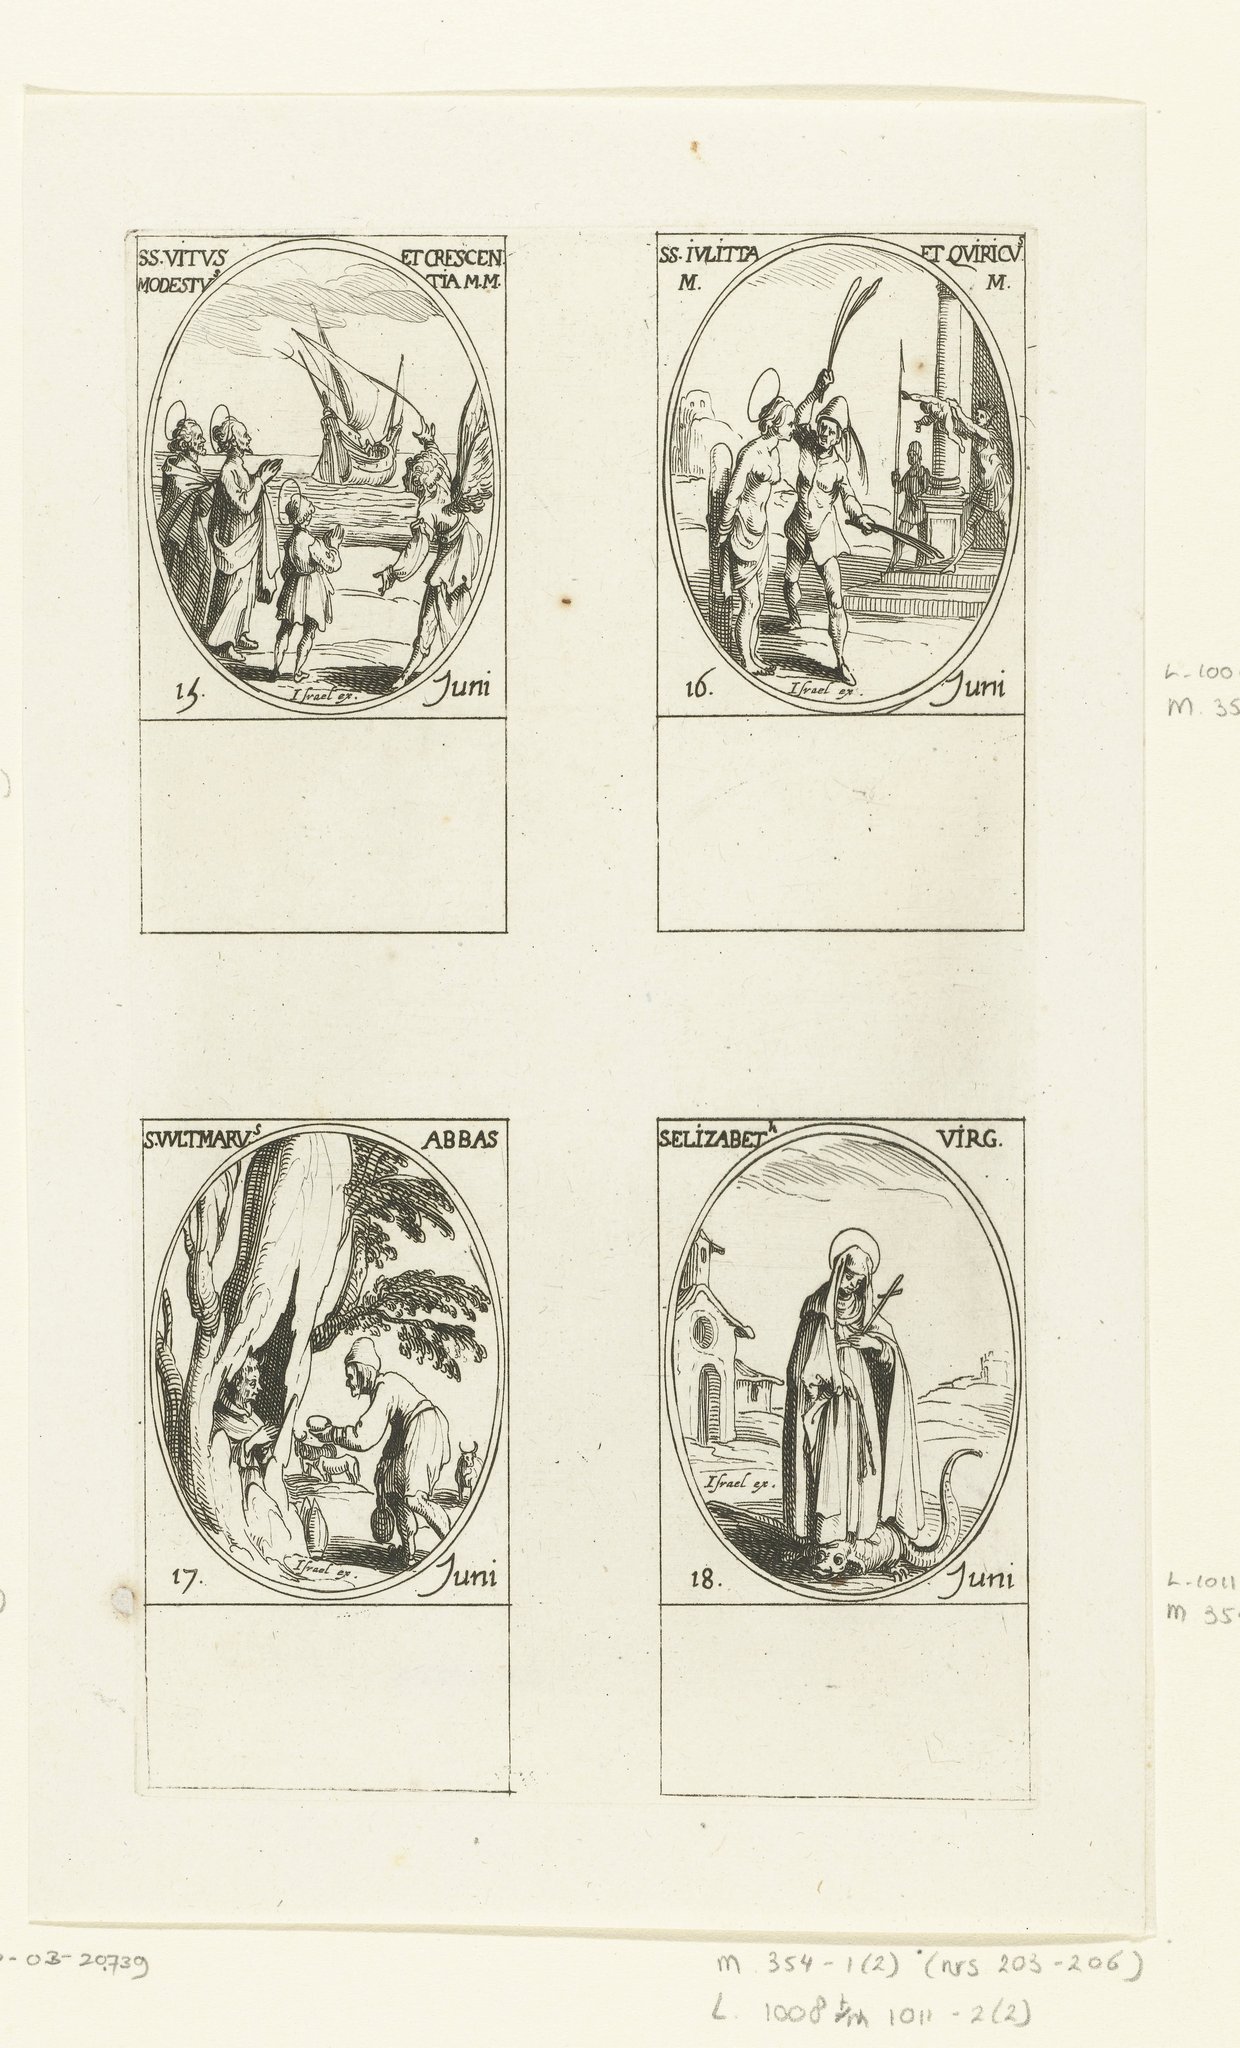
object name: print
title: Alle heiligen en de Christelijke feestdagen van het jaar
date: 1632-1636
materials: paper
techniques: etching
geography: nancy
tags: female saints (with name), male saints (with name), martyrdom, suffering, misfortune, death of st. cyricus & julitta, st. vitus, together with his tutor modestus and his nurse crescentia, escapes from his father's wrath in a boat steered by an angel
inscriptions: collector's mark: Lugt 240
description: Blad met vier ovale voorstellingen, elk met opschrift en datum in het Latijn: linksboven de Heilige Vitus met een engel, zijn verzorgster de Heilige Crescentia en haar man Modestus aan een kust, rechtsboven de Heilige Julitta die geslagen wordt met takkenbossen terwijl haar zoontje Quiricus door een koning gedood wordt, linksonder de Heilige Wulmar in een boom die brood aanneemt van een boer, rechtsonder de Heilige Elisabeth van Schönau die een draak vertrapt. Deze prent is onderdeel van een serie prenten met voorstellingen van de heiligen en de christelijke feestdagen van het jaar. Er zijn steeds vier scènes van één plaat op één blad gedrukt. Inclusief bijbehorend titelblad en frontispice gaat het in totaal om 124 platen (490 voorstellingen). De drie platen met de laatste 12 scènes (de veranderlijke christelijke feestdagen) zijn in de derde staat versneden tot 12 kleine plaatjes, en met een apart titelblad uitgegeven.